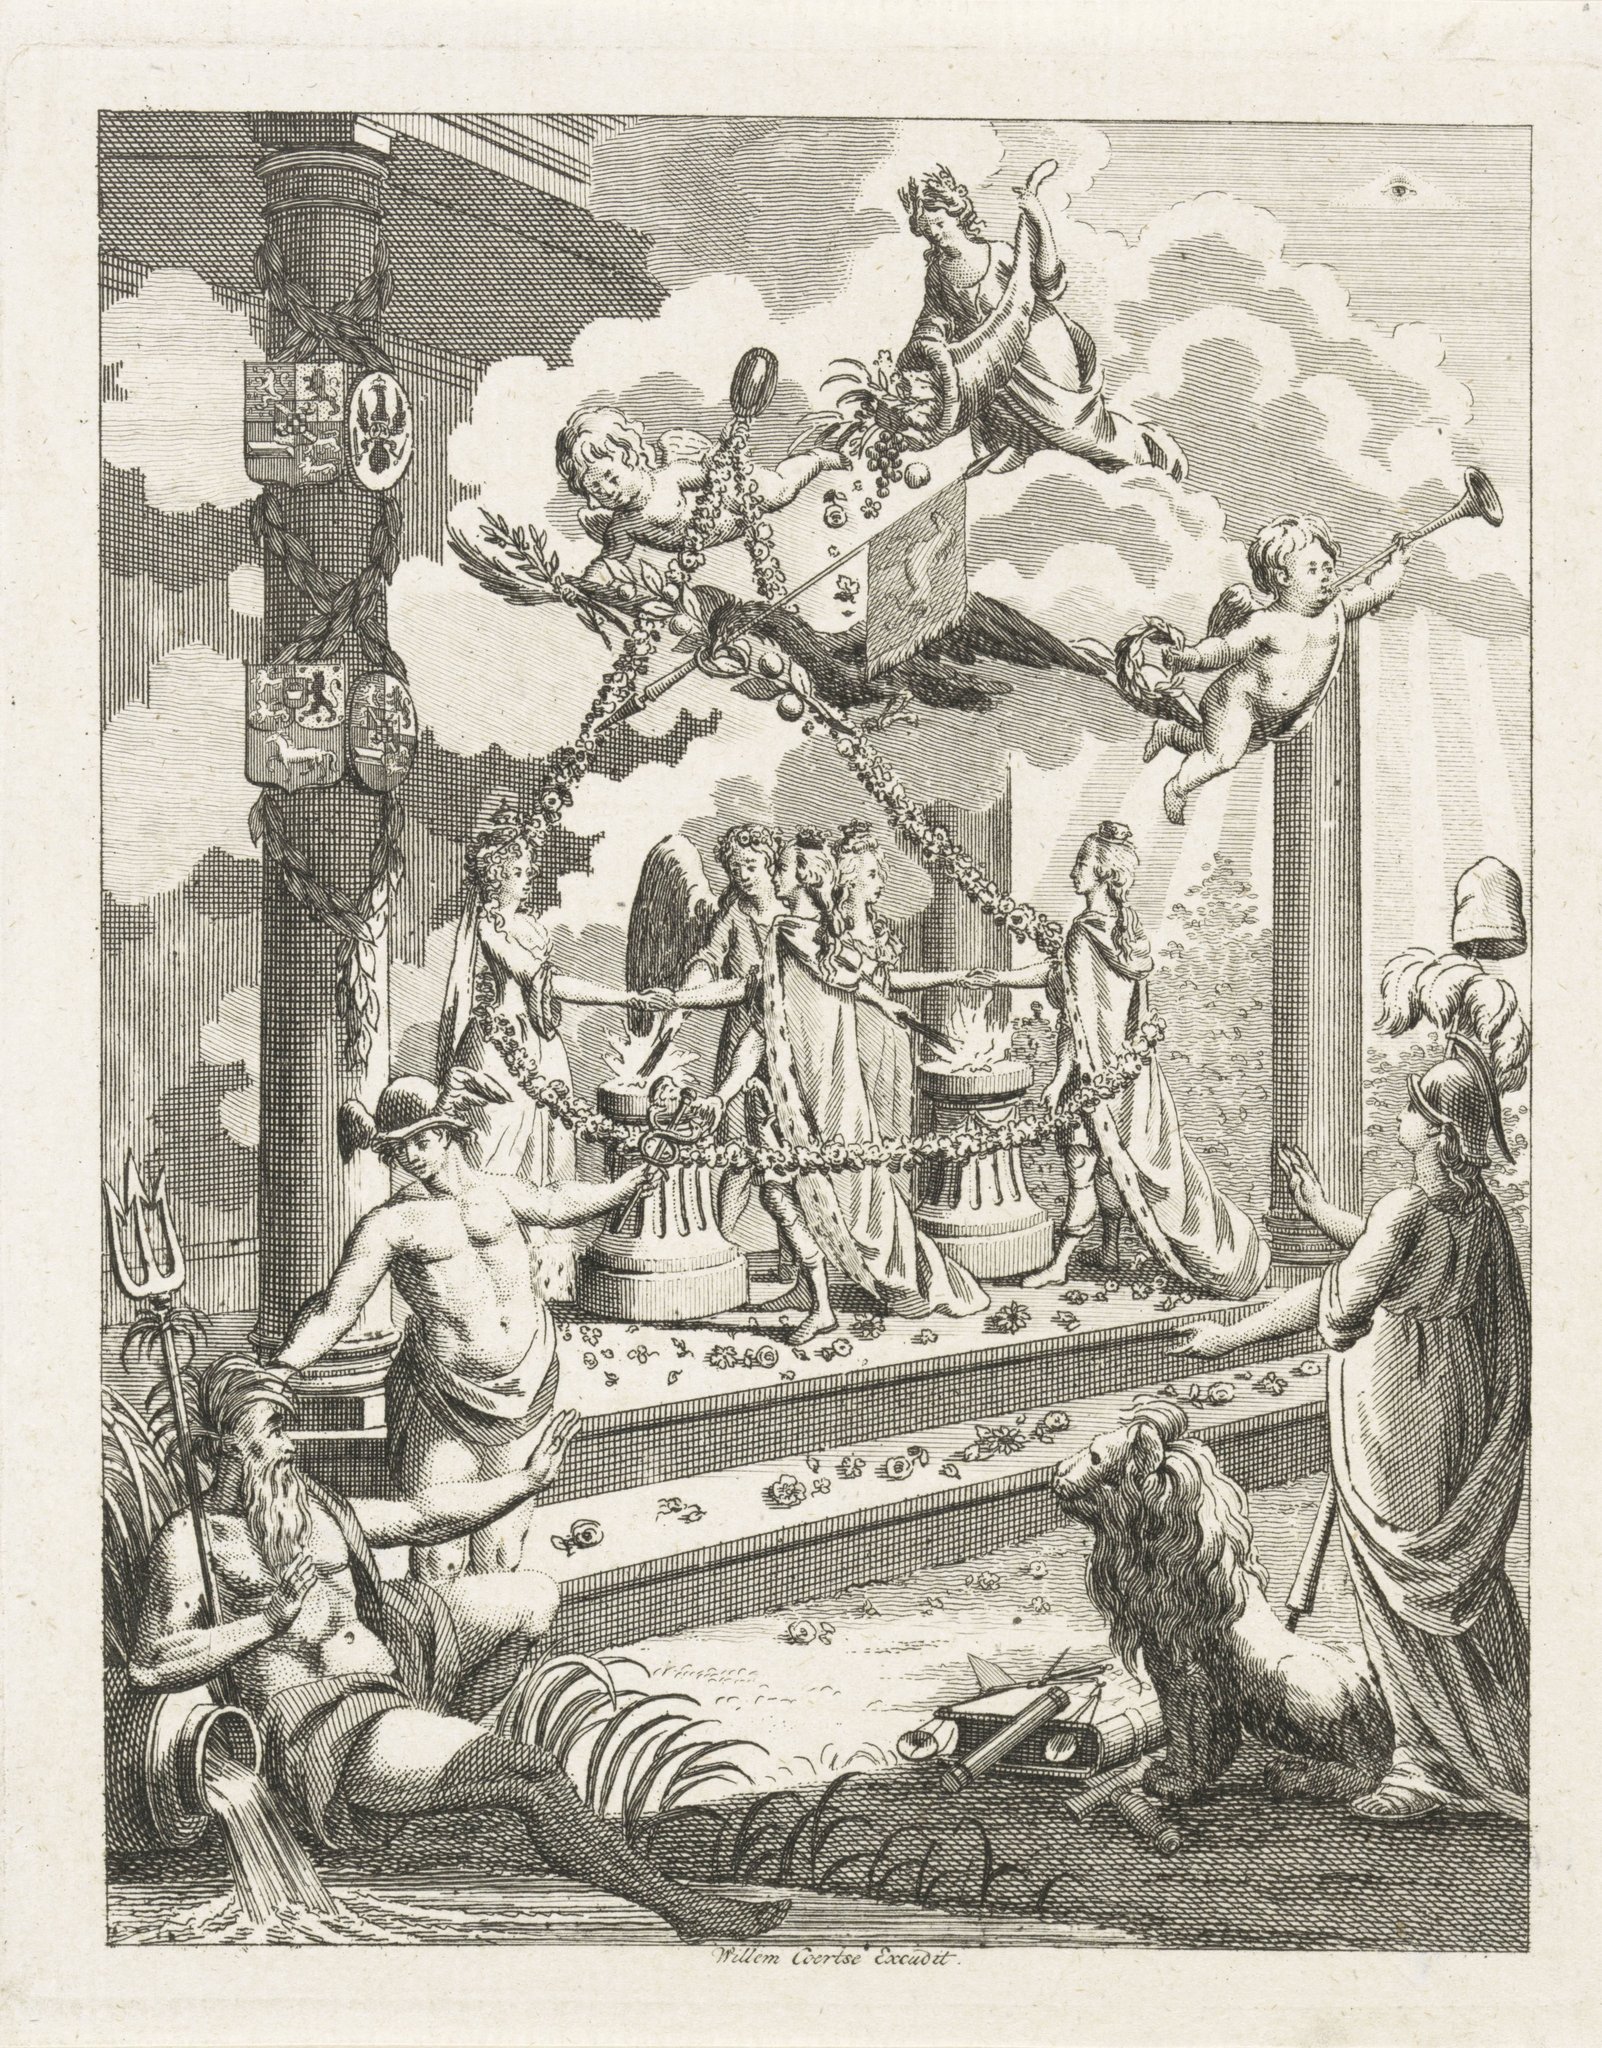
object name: print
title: Zinneprent op de huwelijken van de zoon en dochter van Willem V, 1790-1791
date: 1790-1791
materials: paper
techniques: engraving, etching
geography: northern netherlands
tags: william i of the netherlands, karel van brunswijk-wolfenbüttel, the hague, louise (prinses van oranje-nassau), berlin, wilhelmina frederica louisa (koningin der nederlanden), marriage, married couple, 'matrimonium'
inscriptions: collector's mark: Lugt 2228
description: Allegorische voorstelling bij de huwelijken van prinses Louise van Oranje-Nassau met Karel van Brunswijk-Wolfenbüttel te Den Haag op 14 oktober 1790 en van prins Willem Frederik (de latere koning Willem I) met Wilhelmina Frederica van Pruisen op 1 oktober 1791. De tweebruidsparen bij brandende altaren tussen zuilen voor een tempel door engelen verbonden met bloemenfestoenen. De Nederlandse Maagd, Mercurius en Neptunus zien toe. Bij de prent behoort een verklaring.